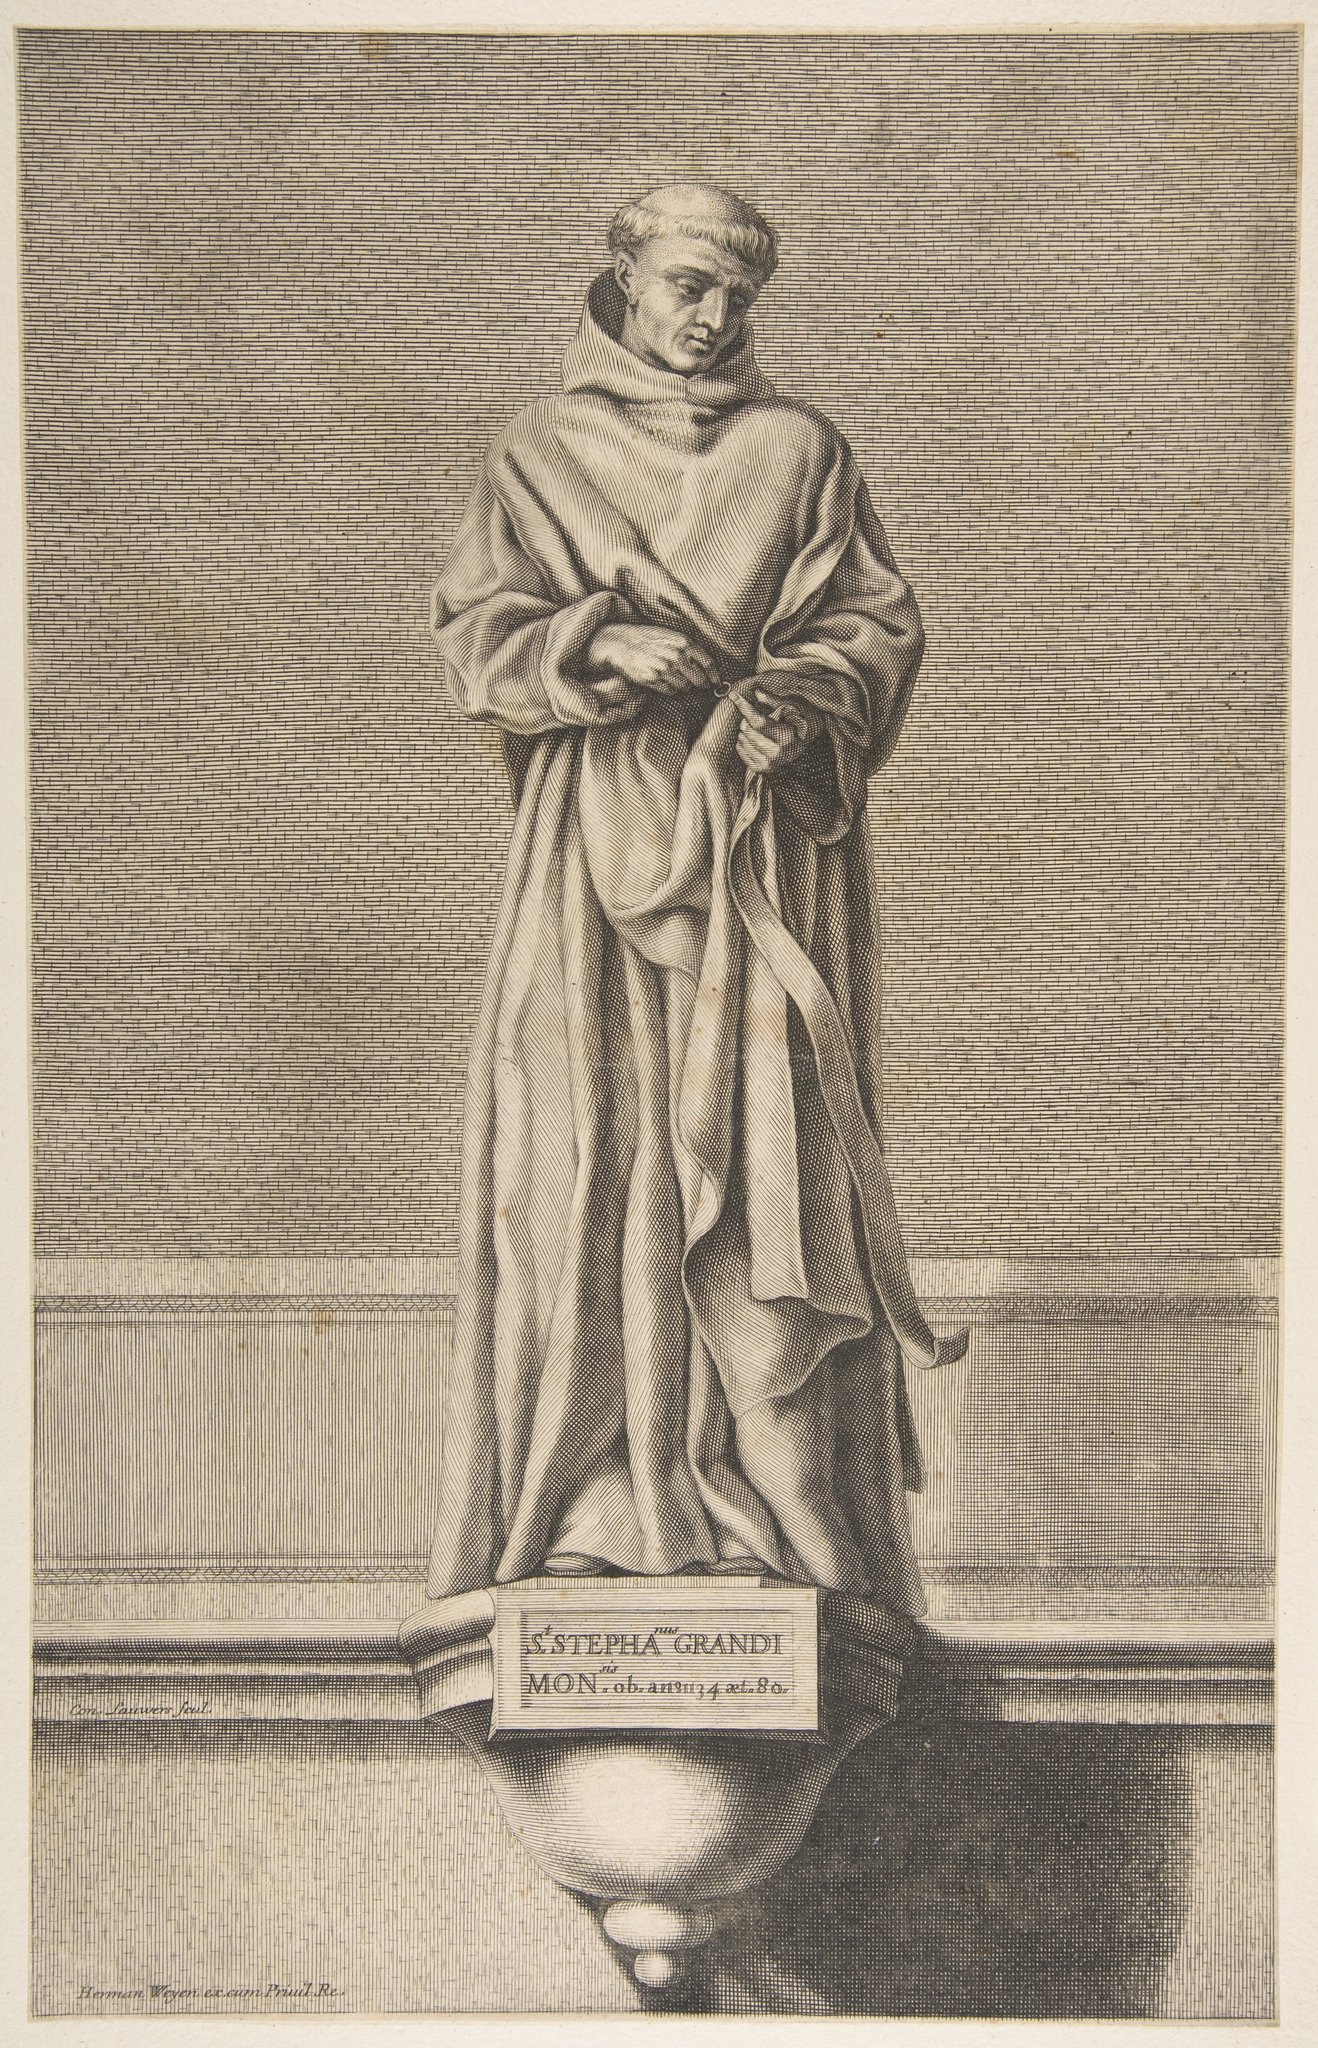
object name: print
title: St. Stephanus Girandi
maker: conrad lauwers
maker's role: artist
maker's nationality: flemish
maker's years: 1632-1685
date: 1601-1700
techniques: engraving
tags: men,saints